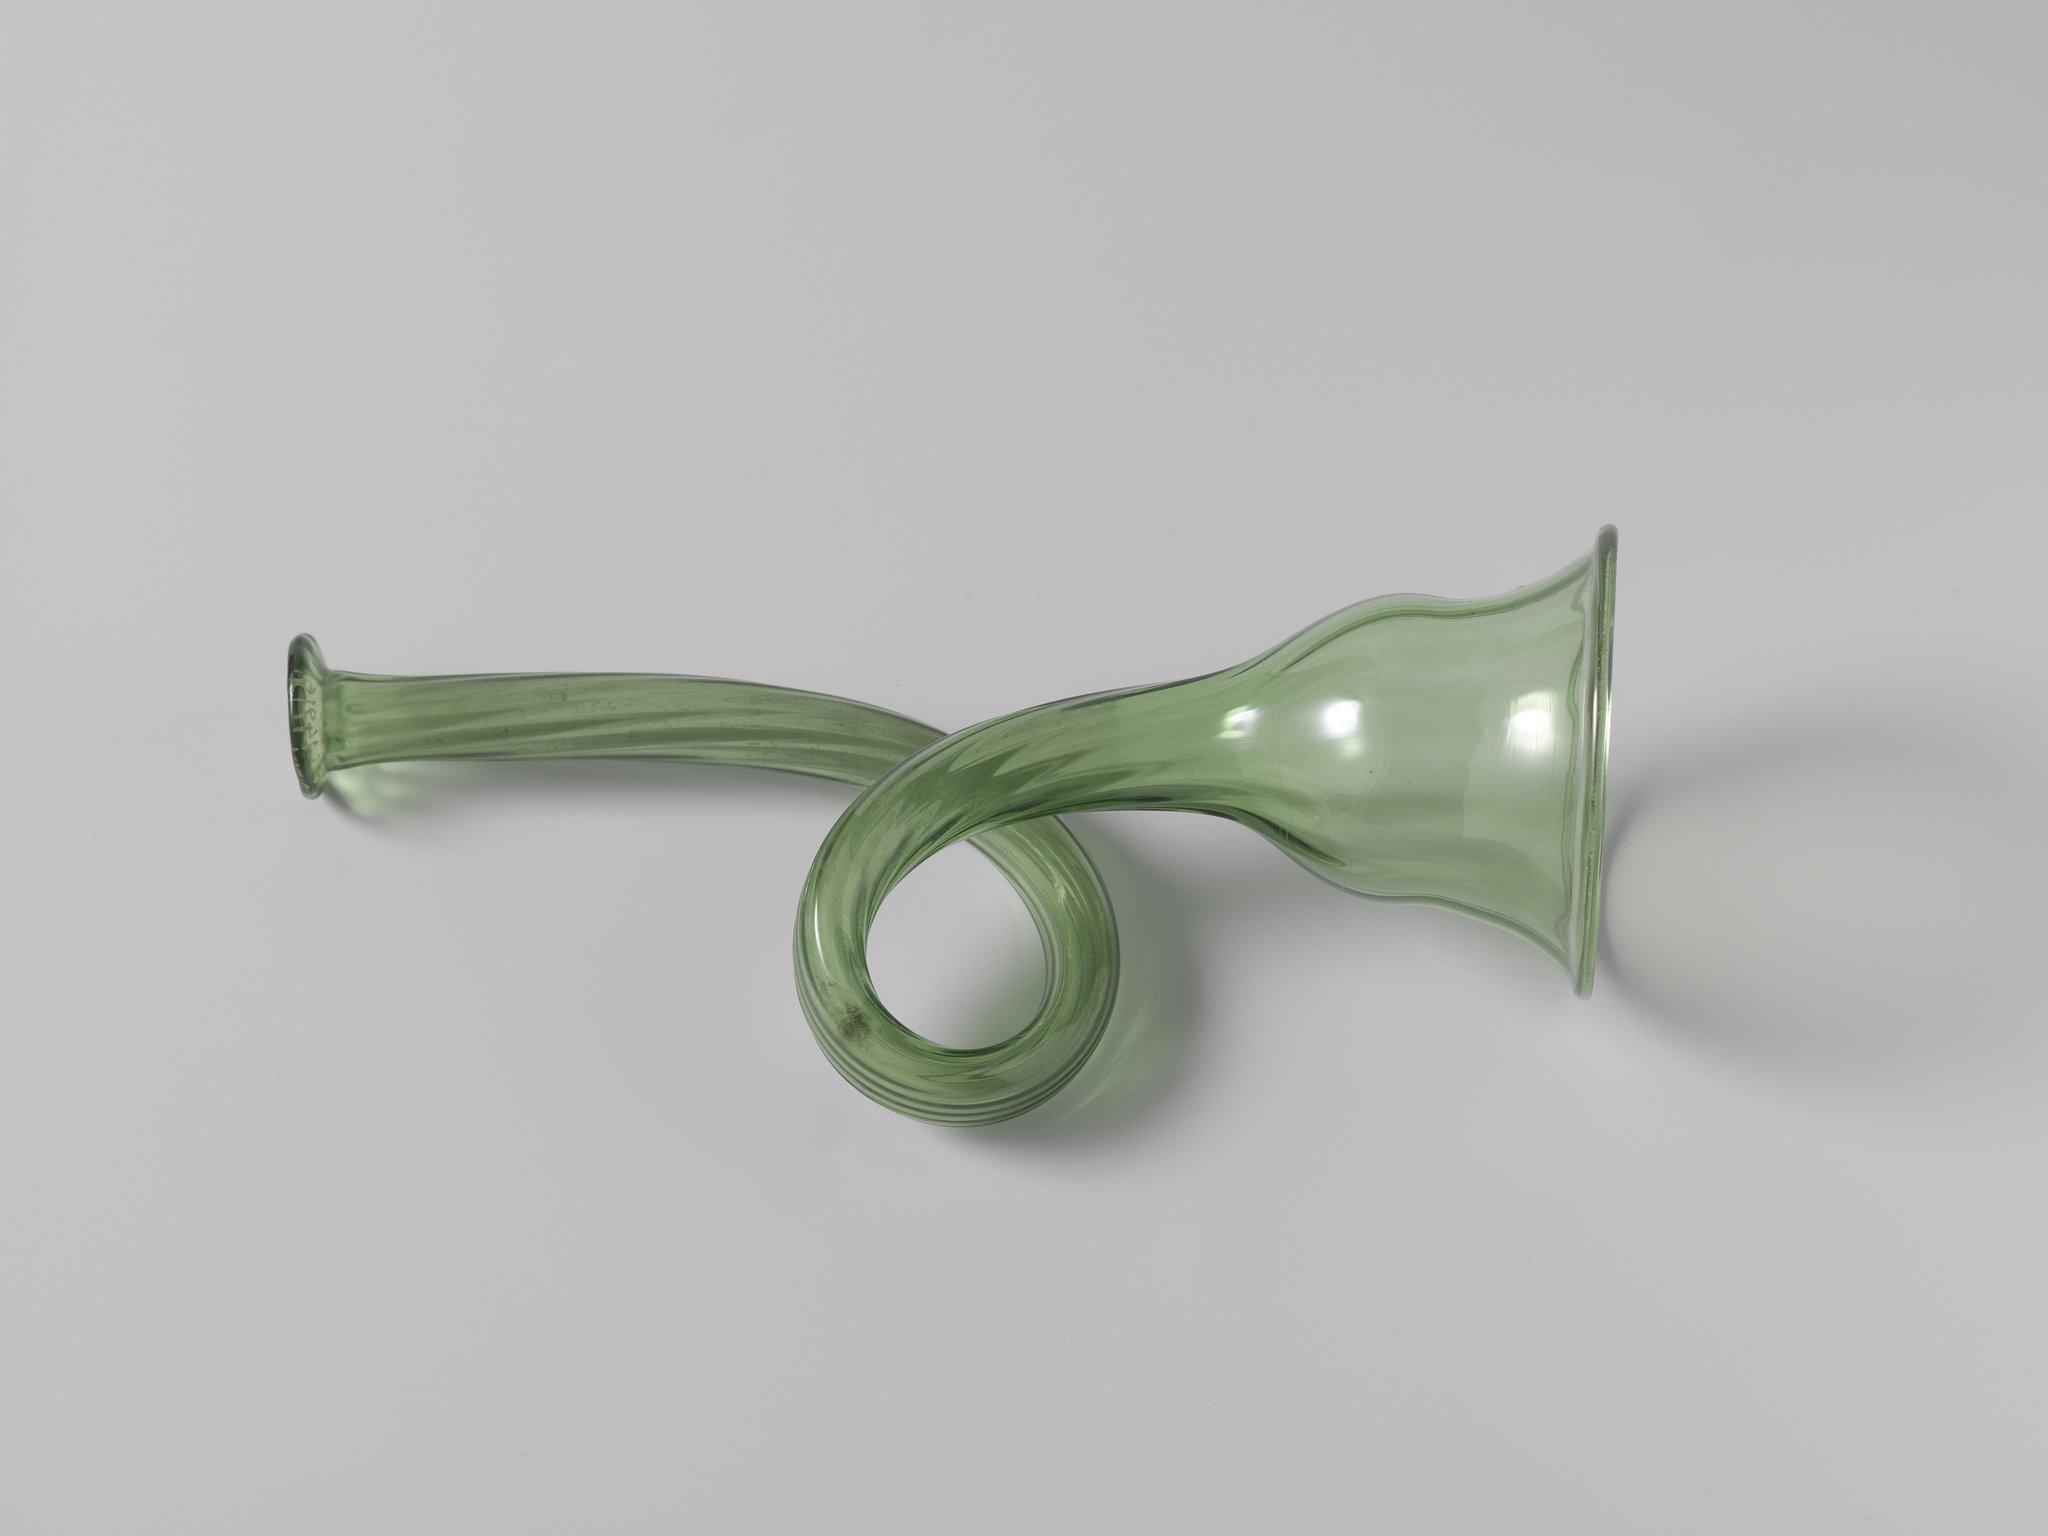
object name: trumpet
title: Glass trumpet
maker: Anonymous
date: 1700-1900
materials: glass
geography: europe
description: Gladde, rondgebogen geribde buis, uitlopend in een klokvormige geribde klankbeker; aan de smalle zijde een uitgebogen mondstuk. Groen glas.